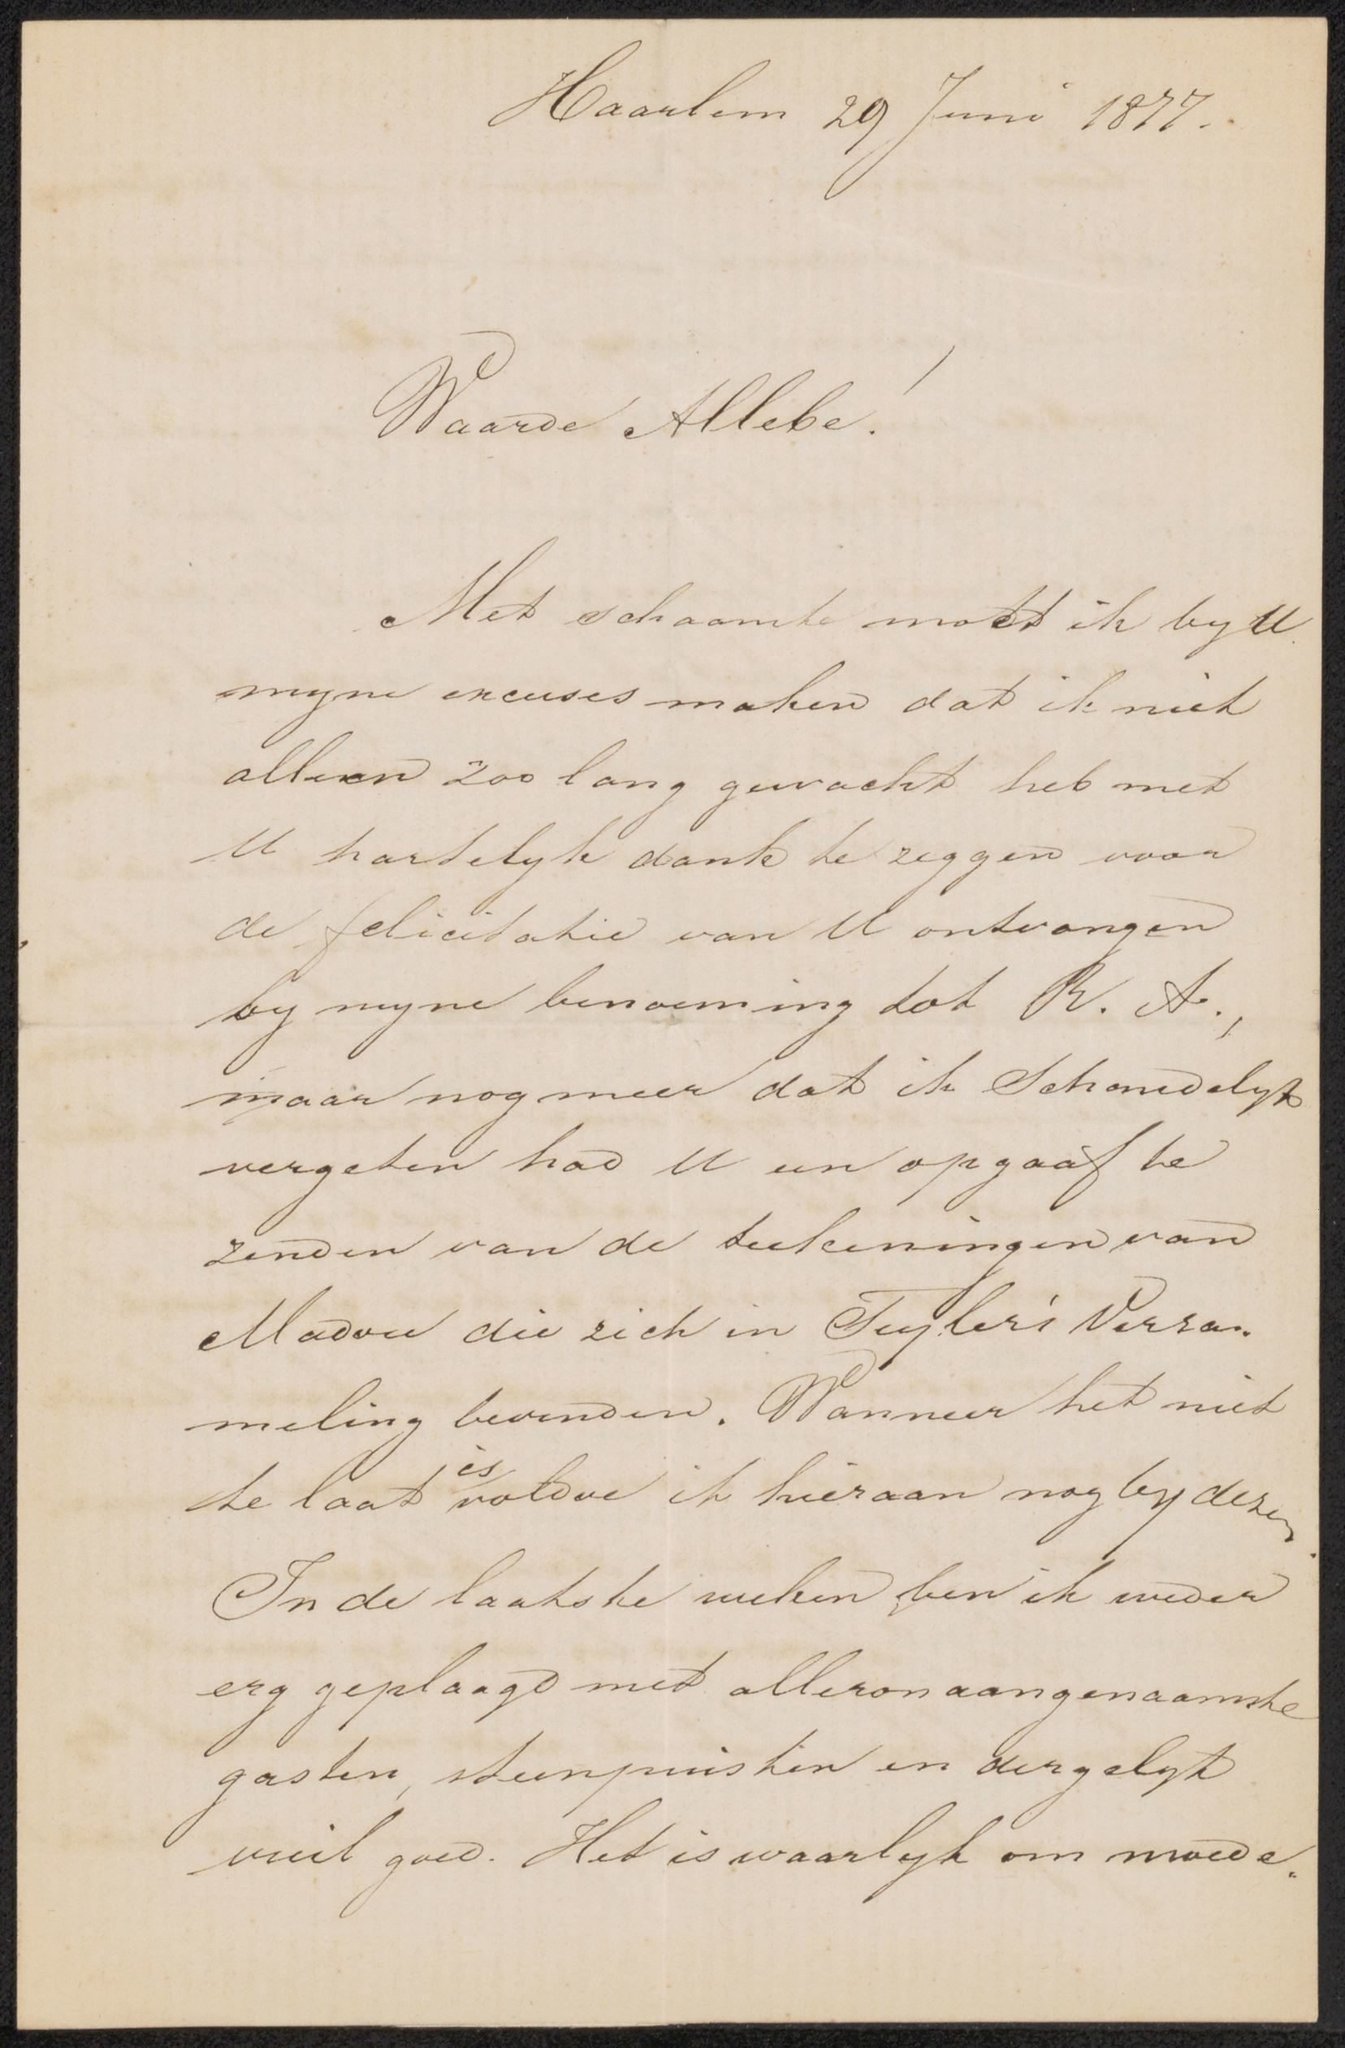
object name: letter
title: Brief aan August Allebé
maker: hendrik jacobus scholten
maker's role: draughtsman, painter, print maker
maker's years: 1824-1907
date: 1877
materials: ink, paper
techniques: pen, writing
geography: haarlem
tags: amsterdam, august allebé, brussels, painter, print maker, draughtsman, jean baptiste madou, artist's model, sitter, drawing, art collecting